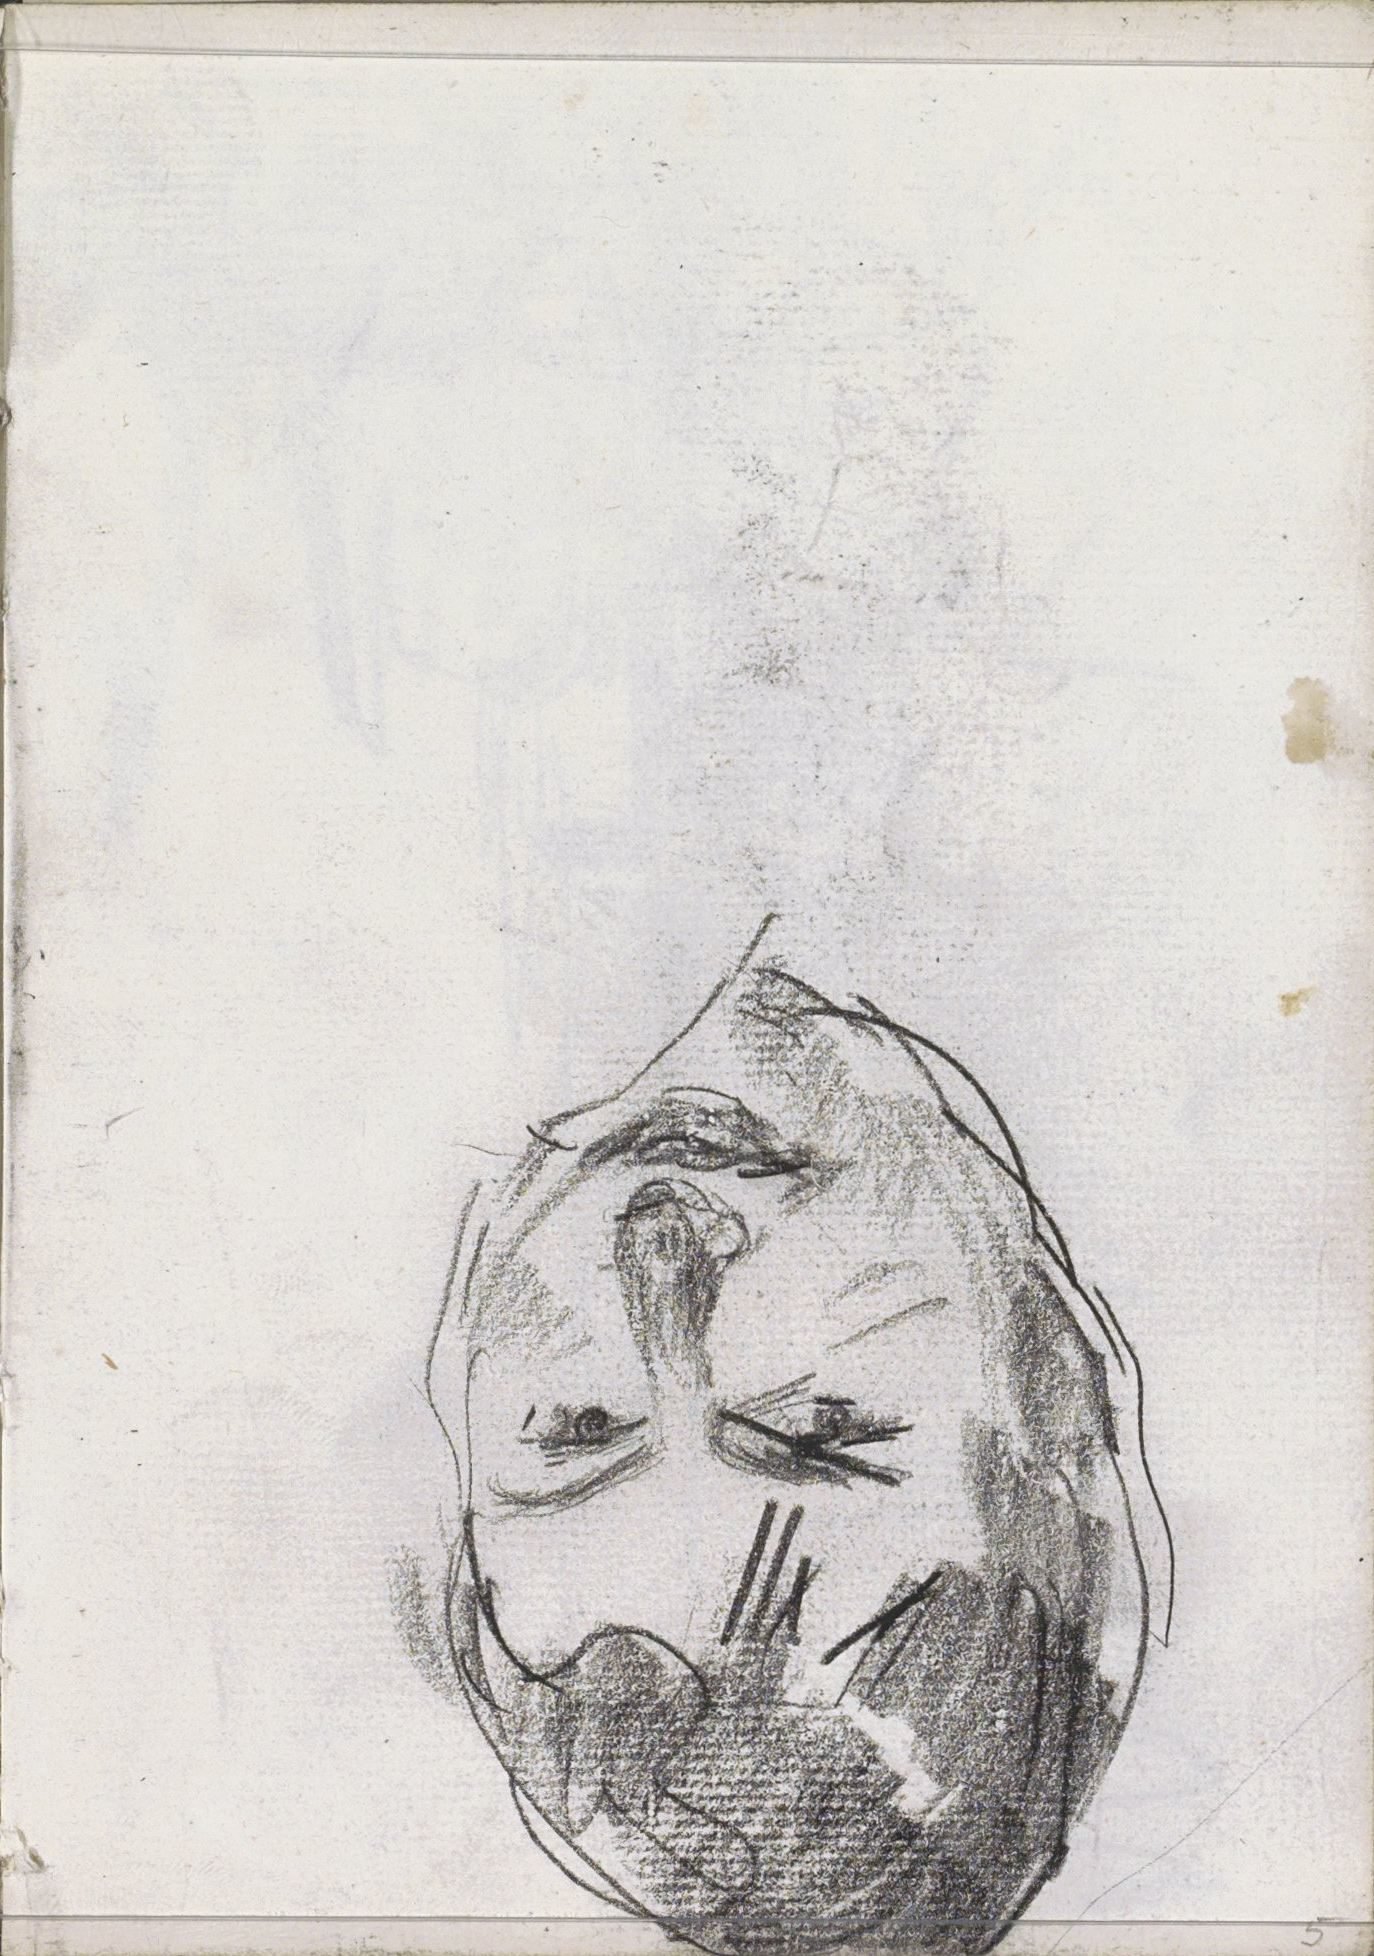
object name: sketchbook leaf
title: Vrouwenhoofd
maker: isaac israels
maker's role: draughtsman, painter, print maker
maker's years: 1865-1934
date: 1886-1934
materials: chalk, paper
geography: amsterdam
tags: head (human) - aa - female human figure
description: Blad 5 recto uit schetsboek LV met 21 bladen.